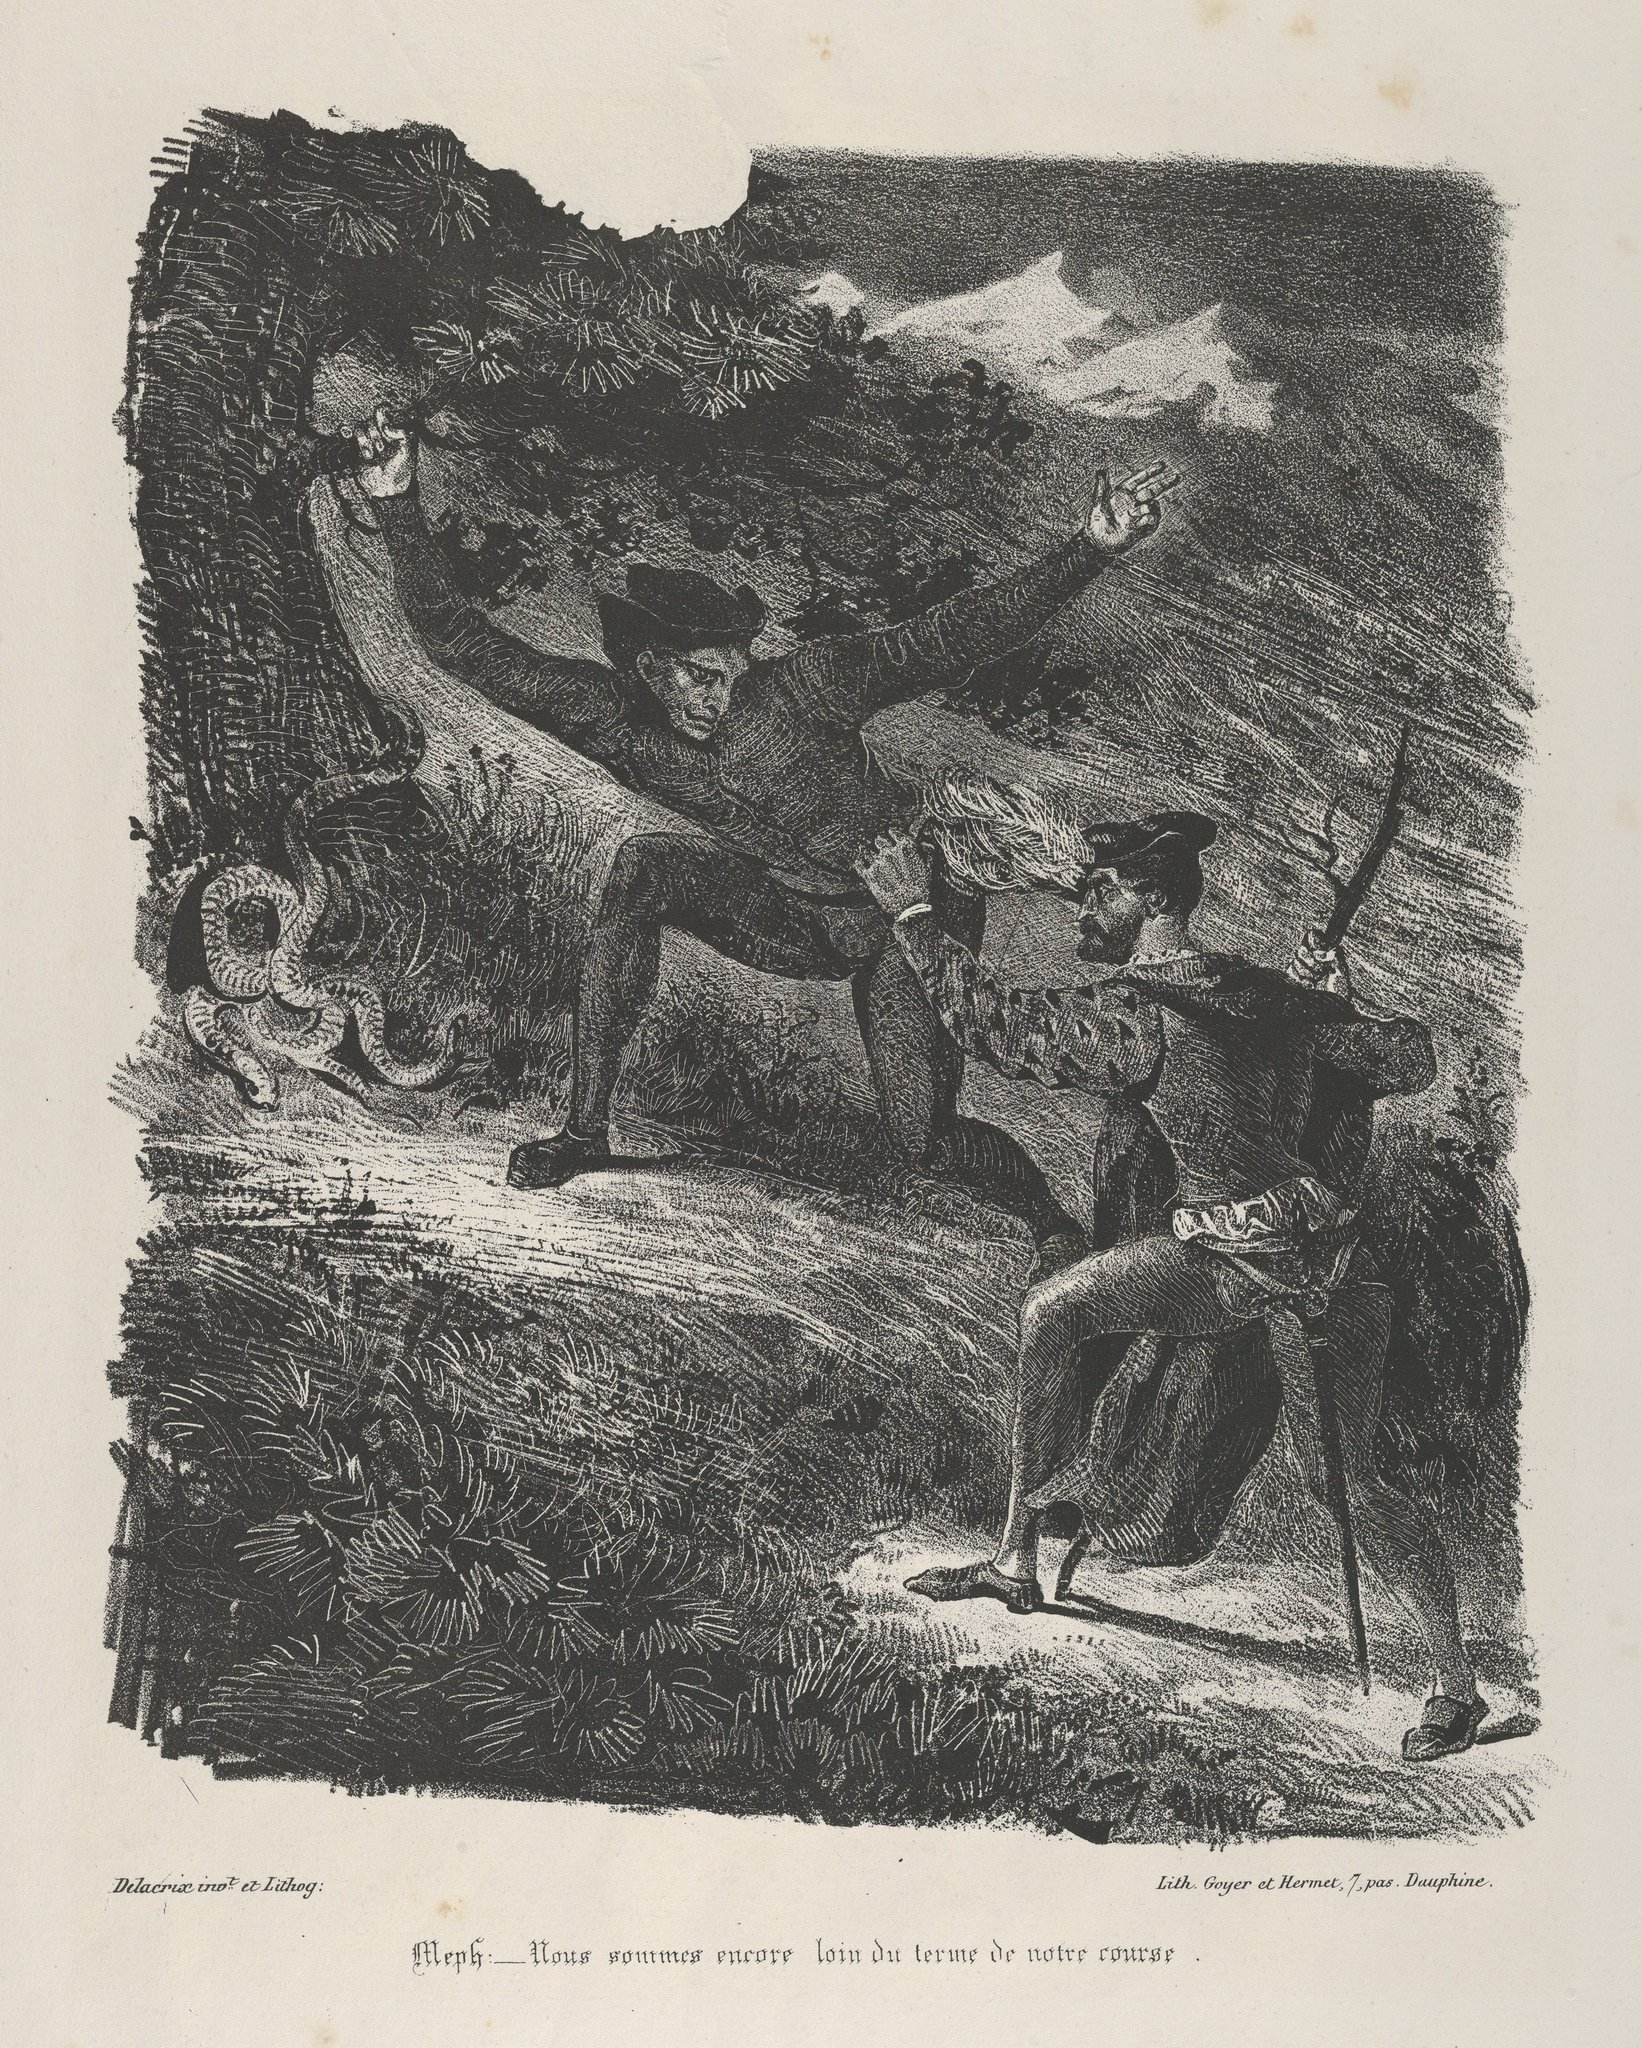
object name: print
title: Faust and Mephistopheles in the Hartz Mountains, from Goethe's "Faust"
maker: eugène delacroix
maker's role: artist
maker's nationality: french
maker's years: 1798-1863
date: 1825-1827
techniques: lithograph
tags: men,snakes,mountains